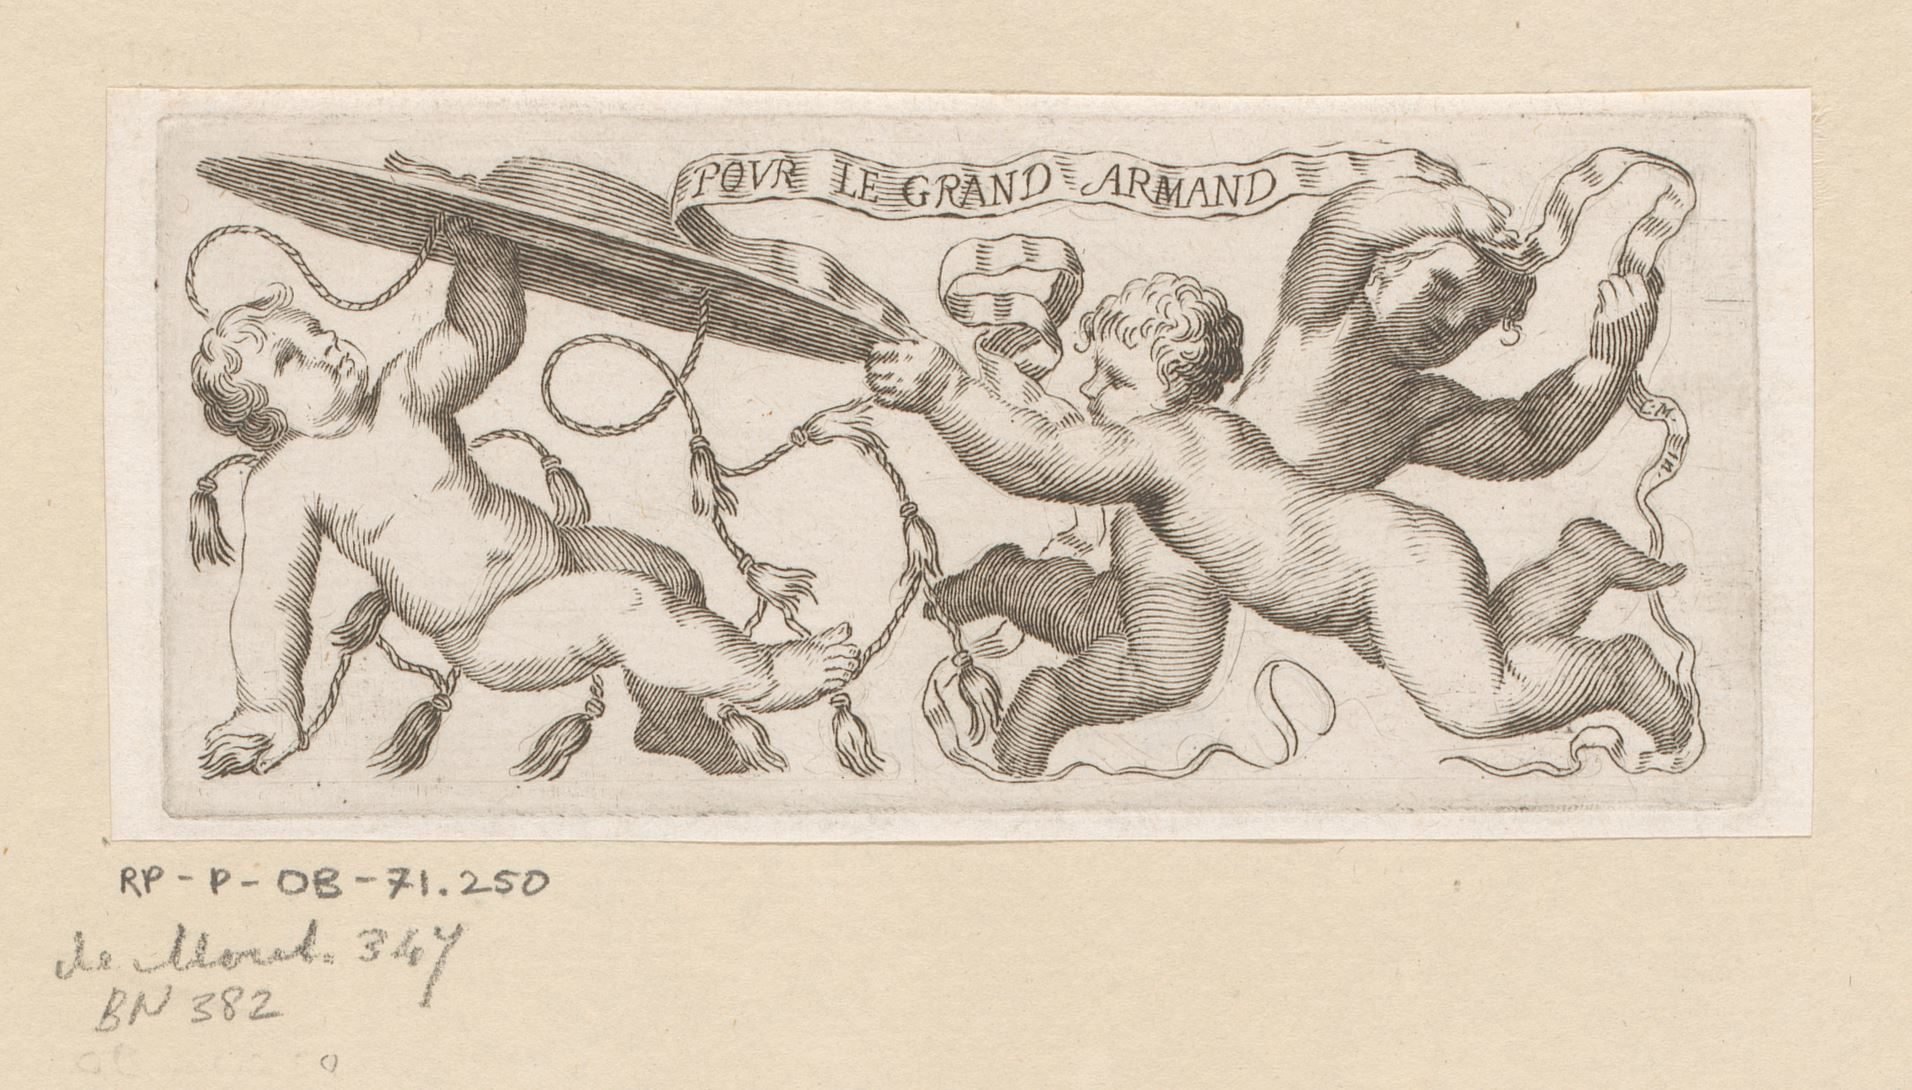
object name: print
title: Drie putti met kardinaalshoed en band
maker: claude mellan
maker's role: draughtsman, print maker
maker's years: 1598-1688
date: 1639-1643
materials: paper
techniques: engraving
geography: paris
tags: insignia of cardinal, e.g. hat, mantle, cupids: 'amores', 'amoretti', 'putti'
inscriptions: collector's mark: Lugt 240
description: Mellan ontwierp deze band voor de Imprimerie Royale (zie ook British Museum, inv.nr. 1851,1213.645). Tussen 1639-1643 werkte Mellan samen met de Imprimerie Royale (IFF 17e siècle, p. 21-22). Hij vervaardigde verschillende vignetten, letters, culs-de-lampe en decoratieve banden (IFF 17e siècle, p. 215-220).